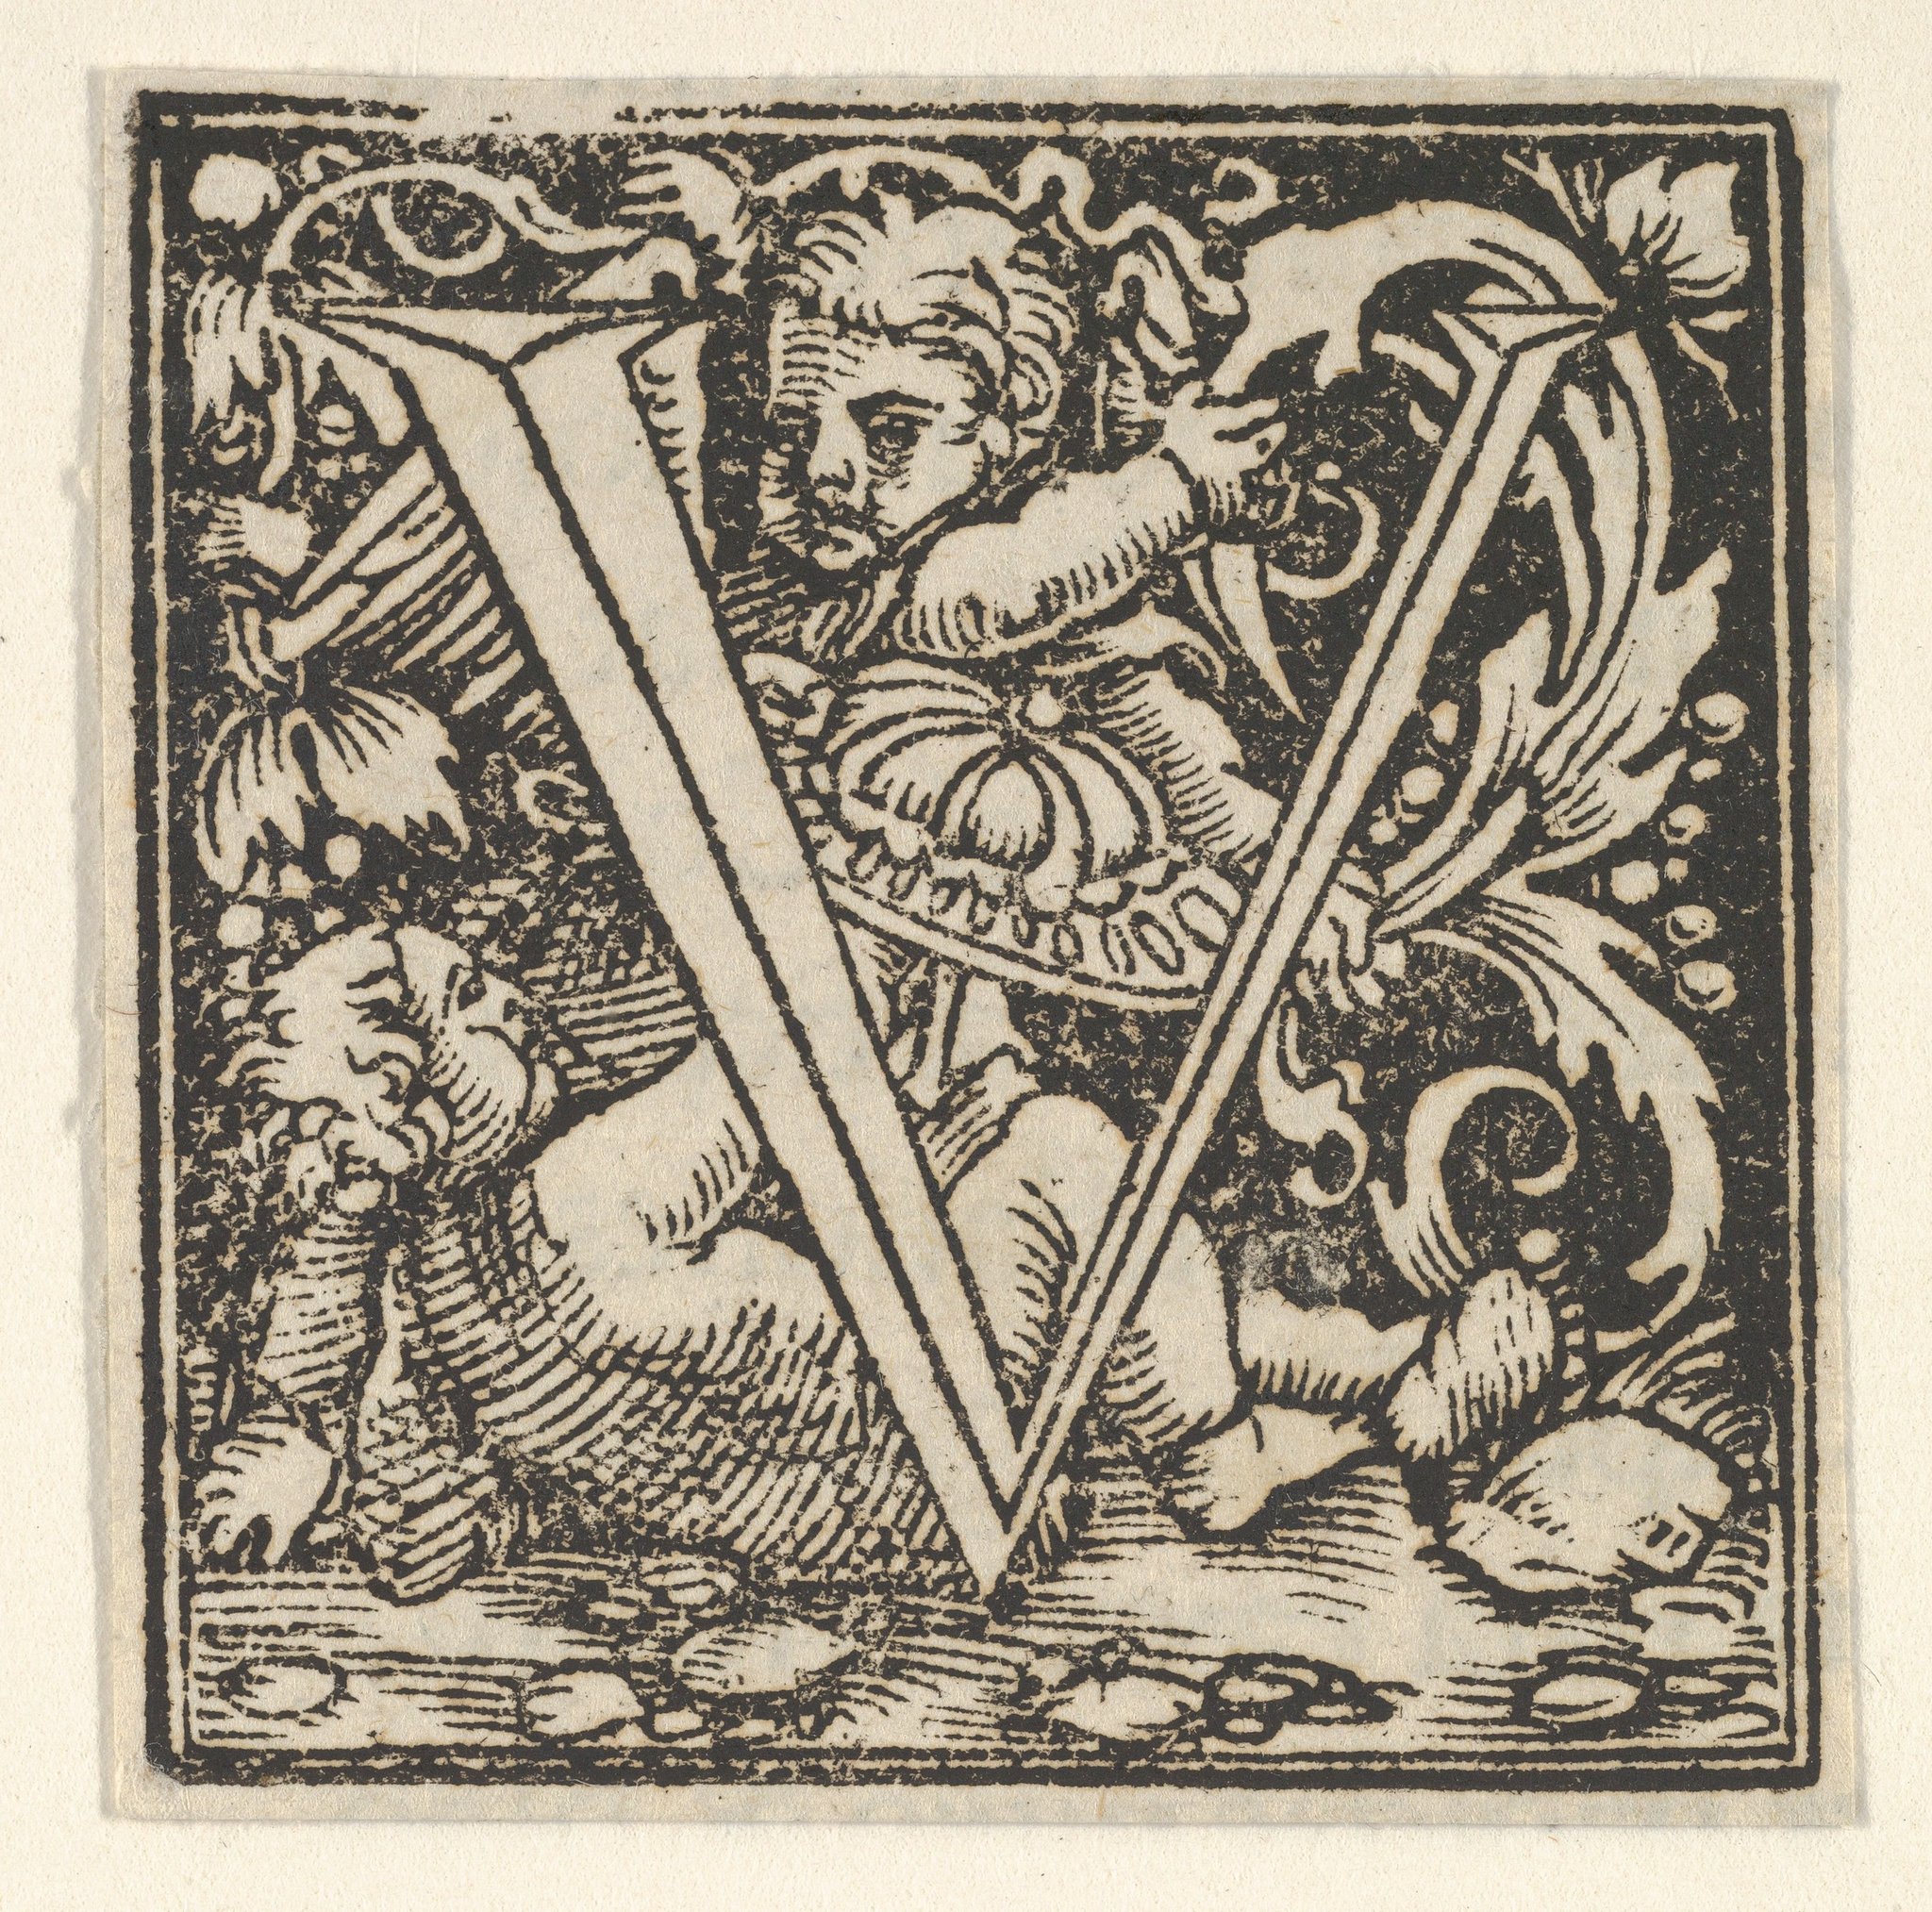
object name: print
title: Initial letter V with putti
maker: heinrich vogtherr the elder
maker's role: artist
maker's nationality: german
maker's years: 1538-1540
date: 1538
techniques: woodcut